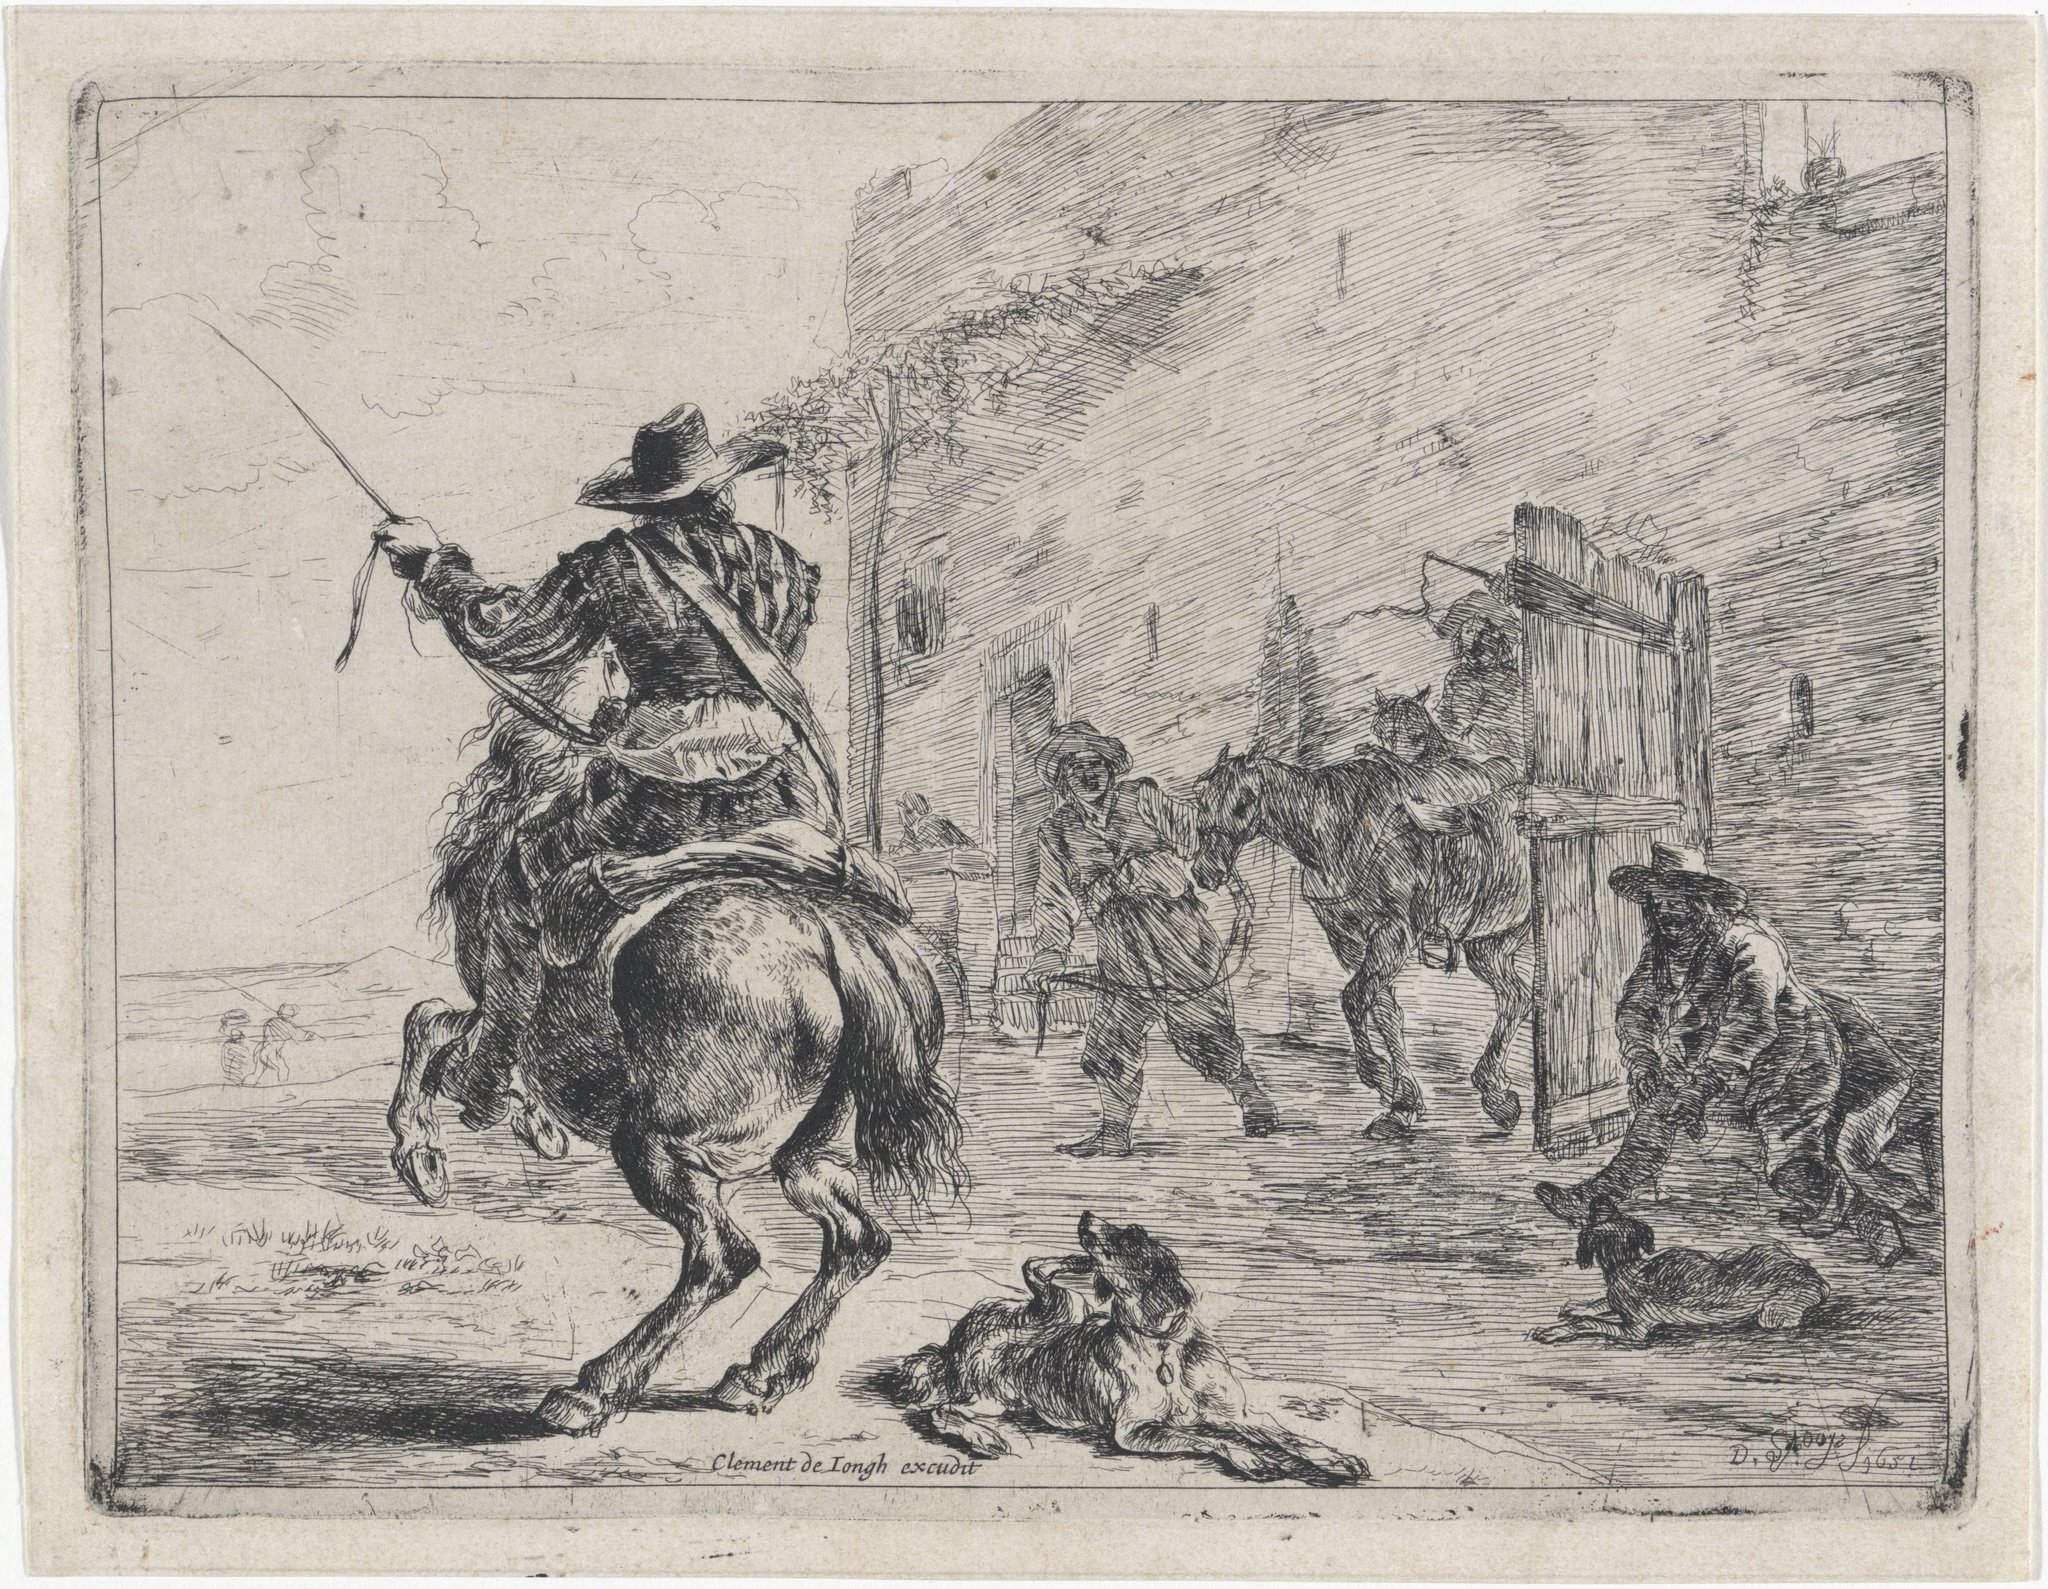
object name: print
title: Steigerend paard bij een stal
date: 1651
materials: paper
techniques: etching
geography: amsterdam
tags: horse, stall, stable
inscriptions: collector's mark: Lugt 2228, collector's mark: Lugt 240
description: Een ruiter met een zweep in de hand zit op een steigerend paard. Rechts leidt een man een paard aan de teugels uit een stal. Op de voorgrond een liggende hond.